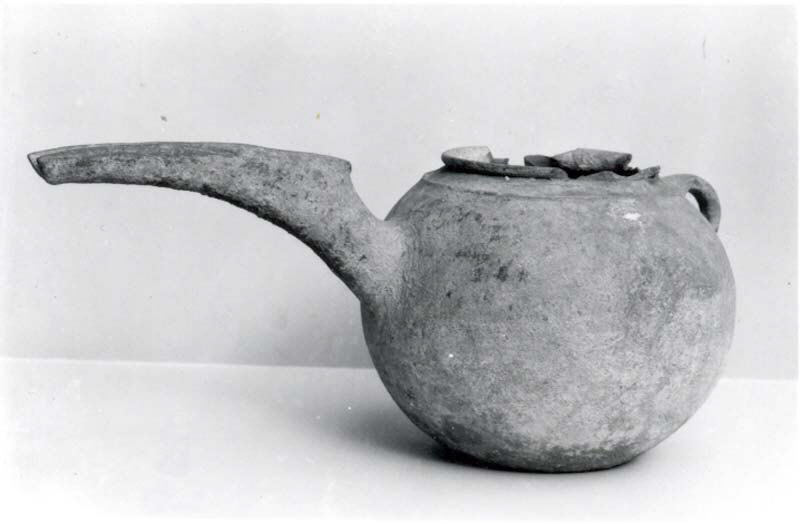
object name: jar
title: Spouted jar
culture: iranian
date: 1900 BCE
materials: ceramic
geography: iran